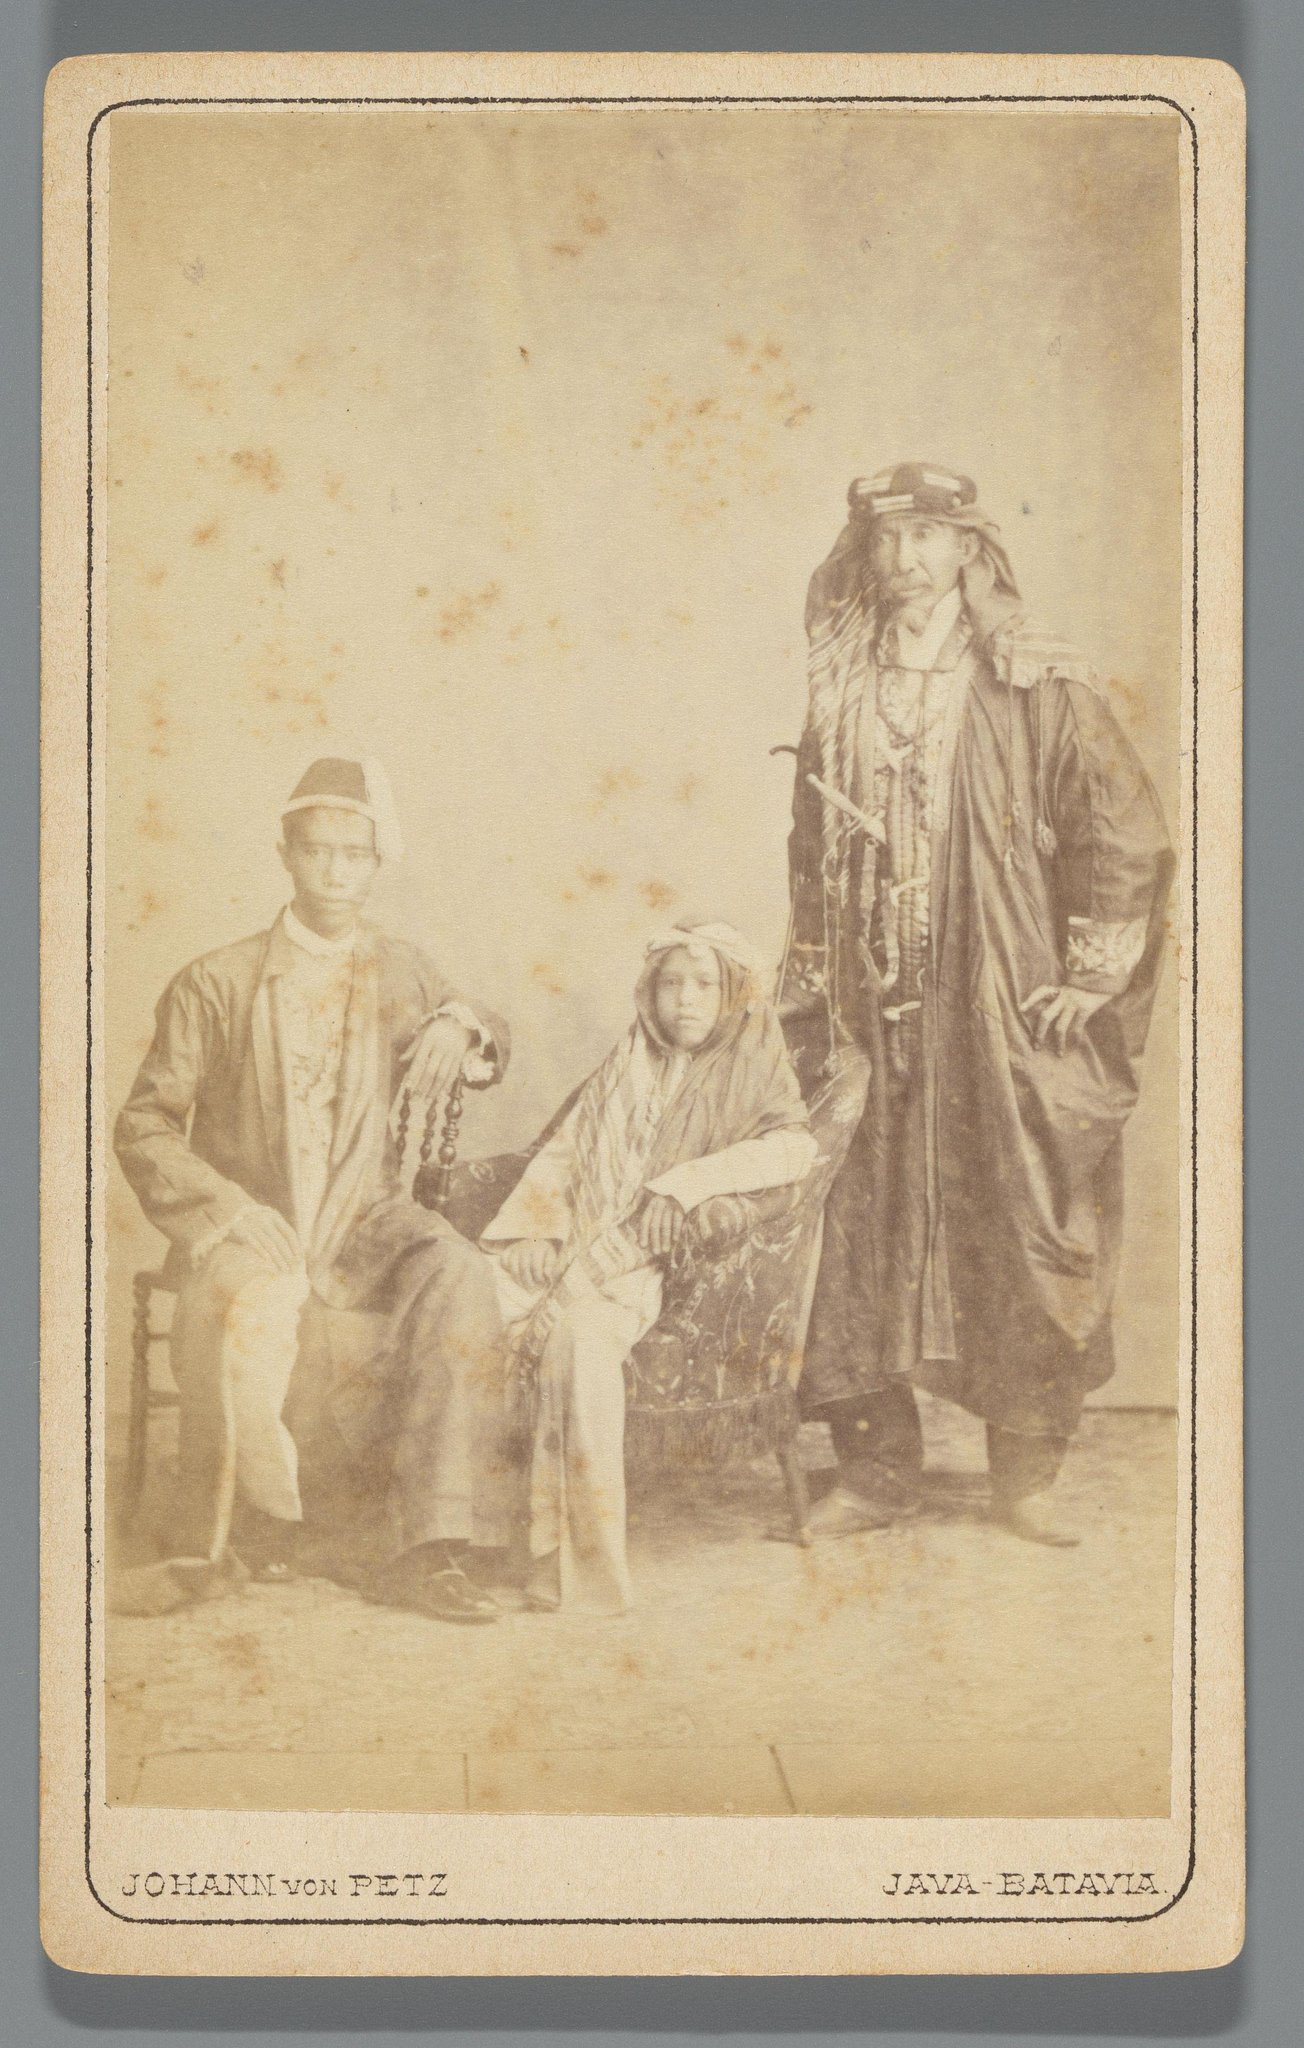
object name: photograph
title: Portret van drie mannen: twee zittend en de rechter staand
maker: johann von petz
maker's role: fotograaf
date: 1860-1910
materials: cardboard, photographic support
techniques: albumen print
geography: java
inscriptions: name, number: ‘B3’, name: ‘JOHANN VON PETZ JAVA-BATAVIA.’